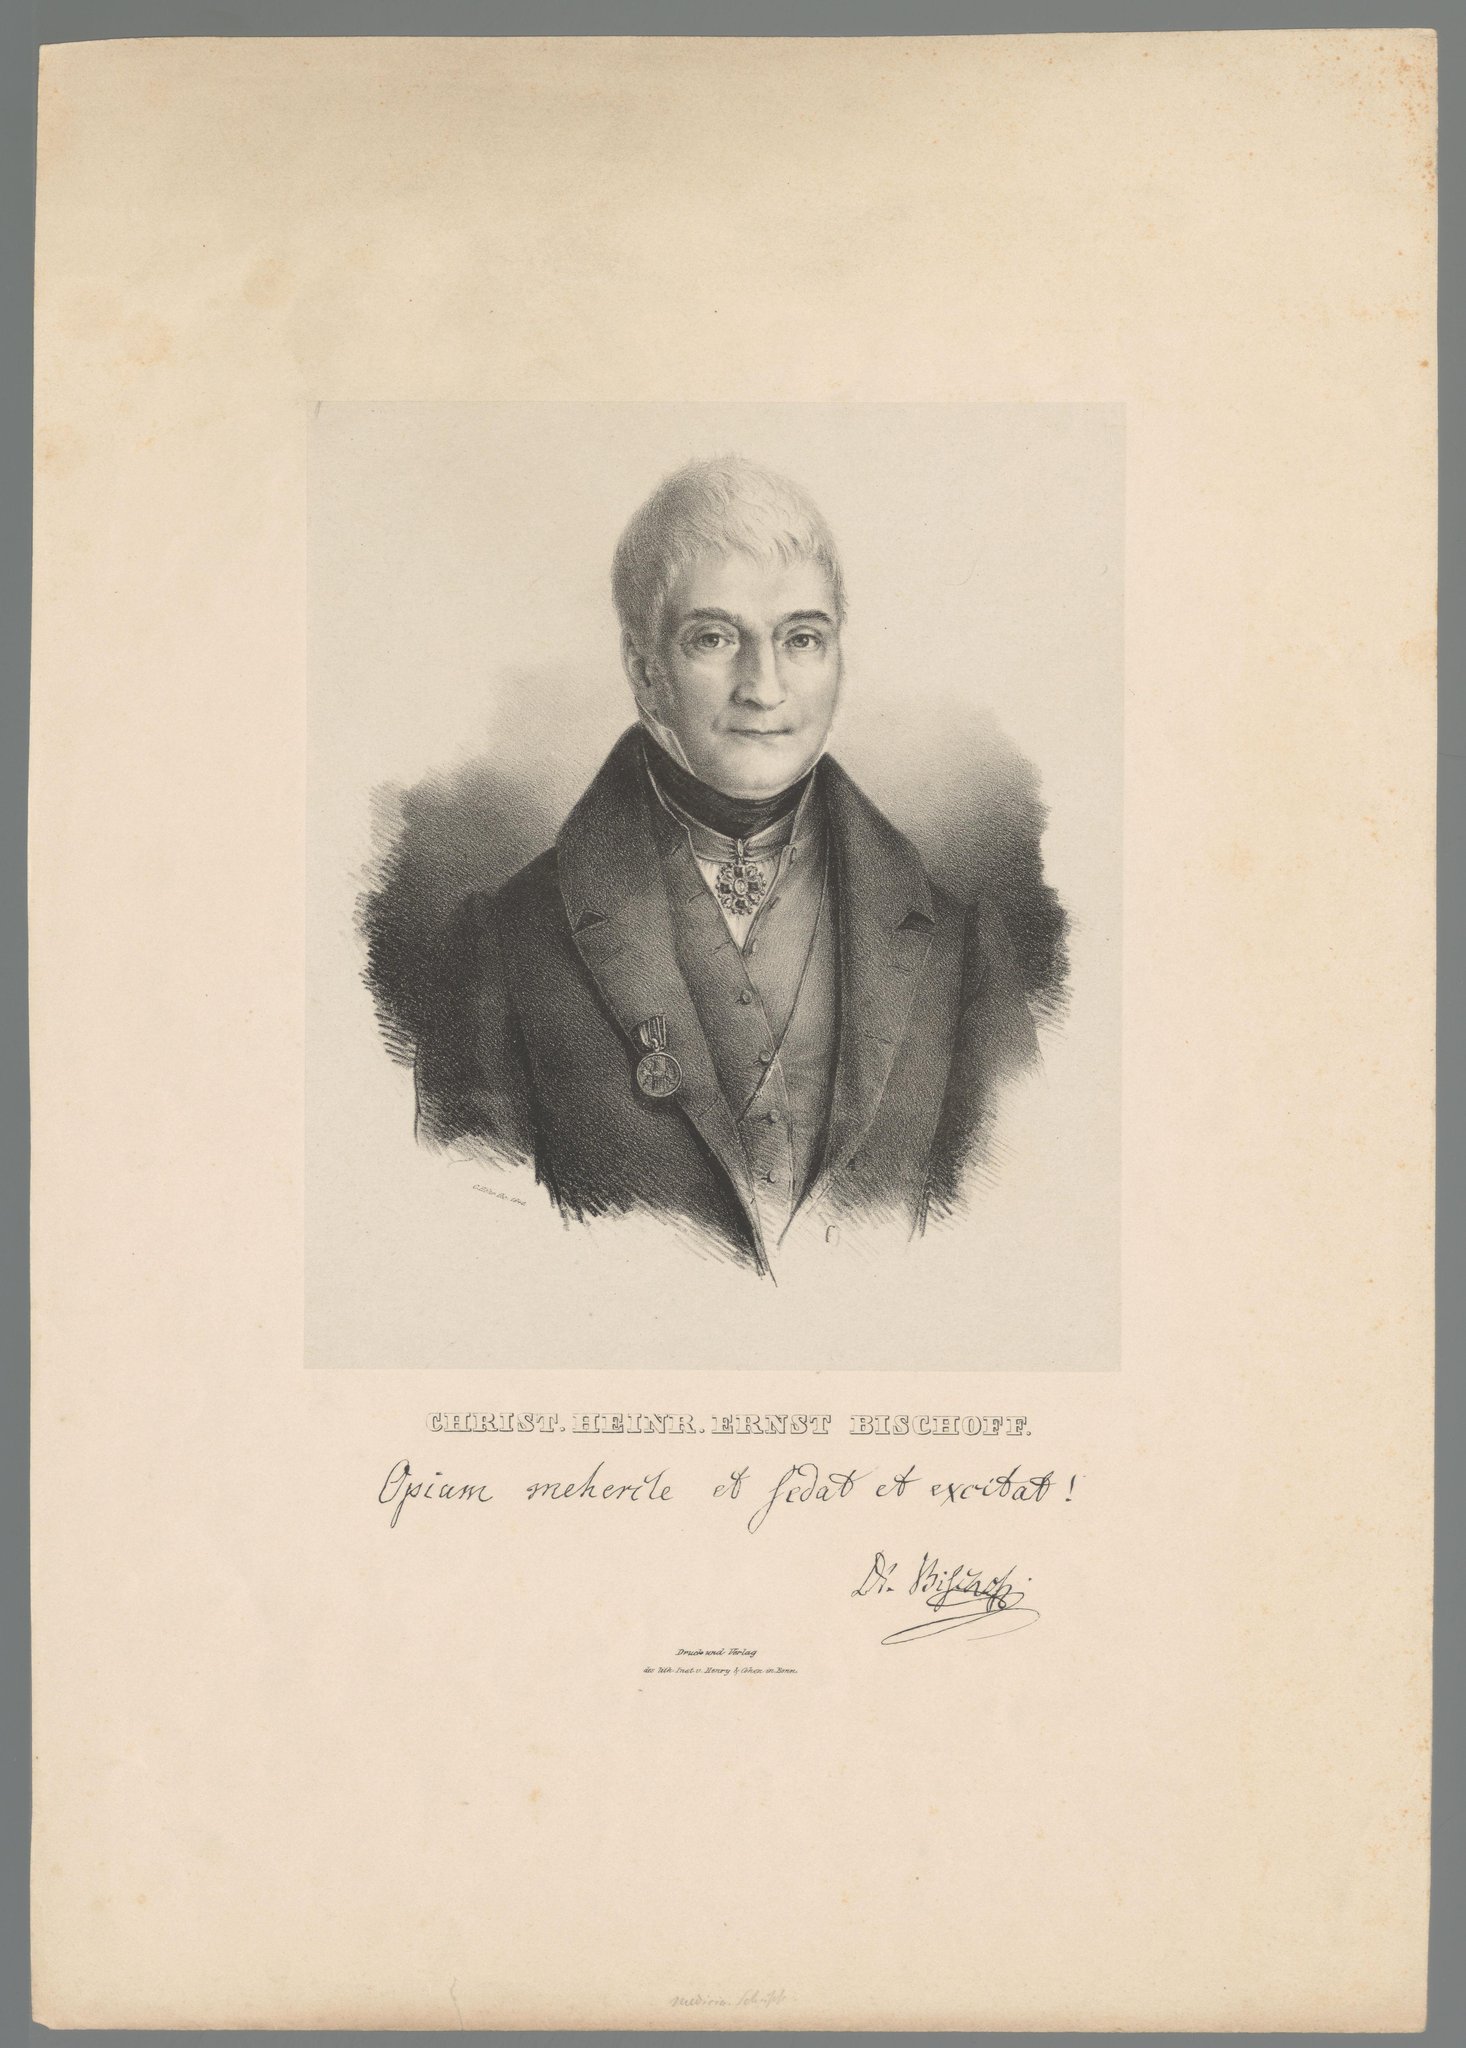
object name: print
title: Christ. Heinr. Ernst Bischoff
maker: christian hohe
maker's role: print maker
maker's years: 1798-1868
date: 1840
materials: paper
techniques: lithograph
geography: bonn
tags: adult man, historical persons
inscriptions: collector's mark: Lugt 2228